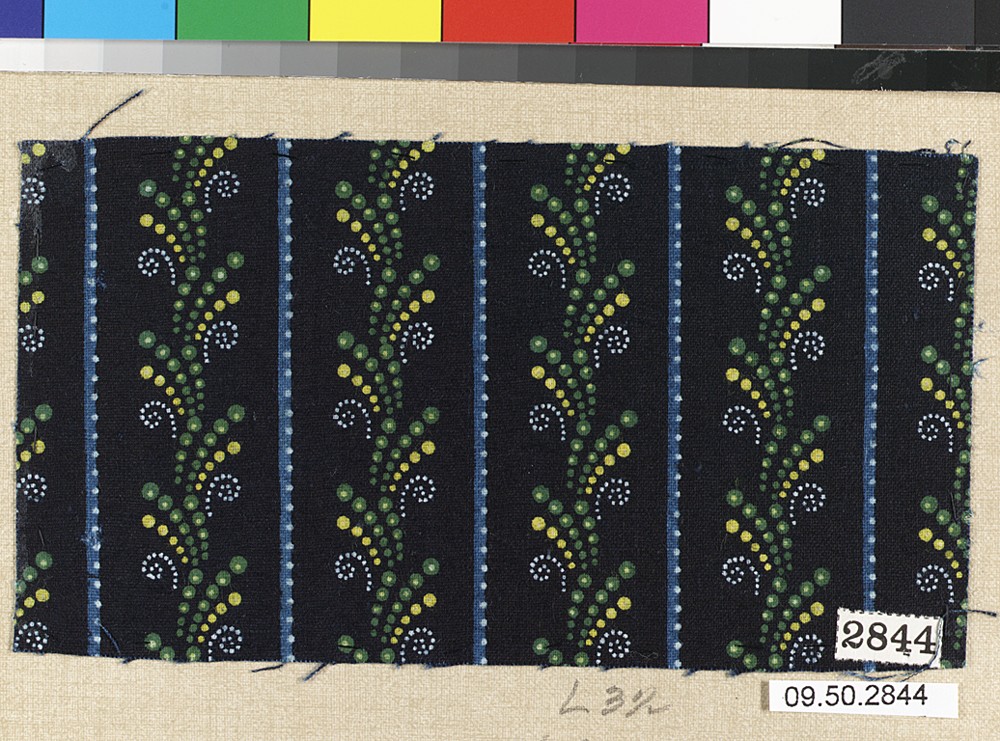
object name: piece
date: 1801-1900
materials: cotton